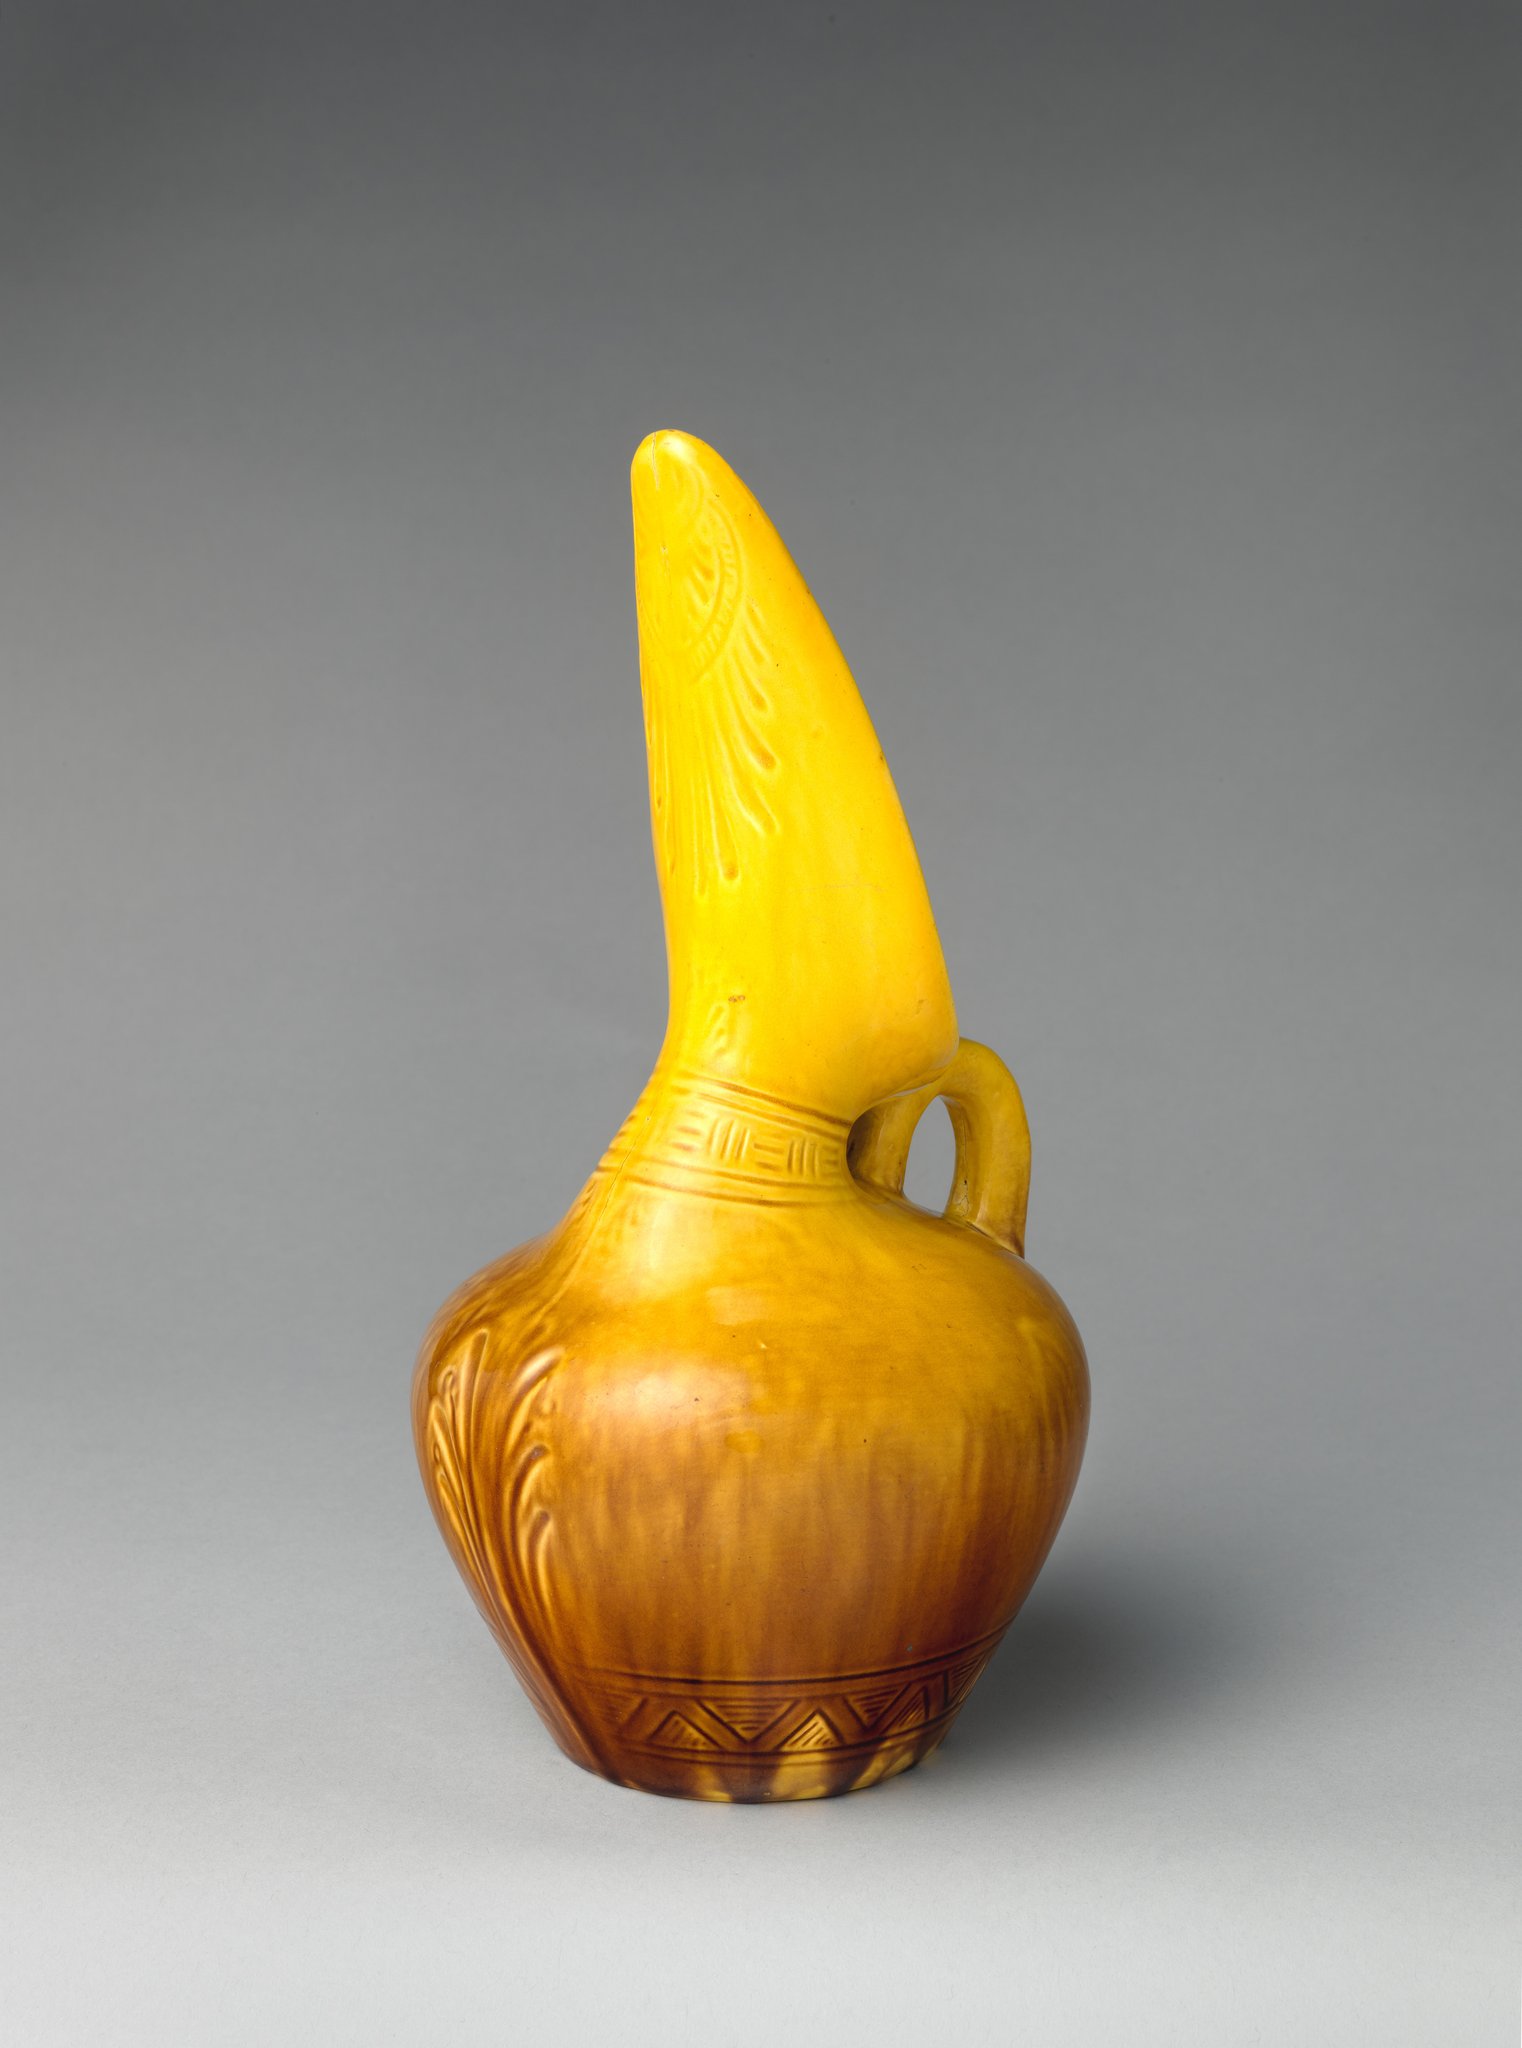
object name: jug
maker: christopher dresser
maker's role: designer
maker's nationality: british, scottish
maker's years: 1834-1904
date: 1892-1896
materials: earthenware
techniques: glazing